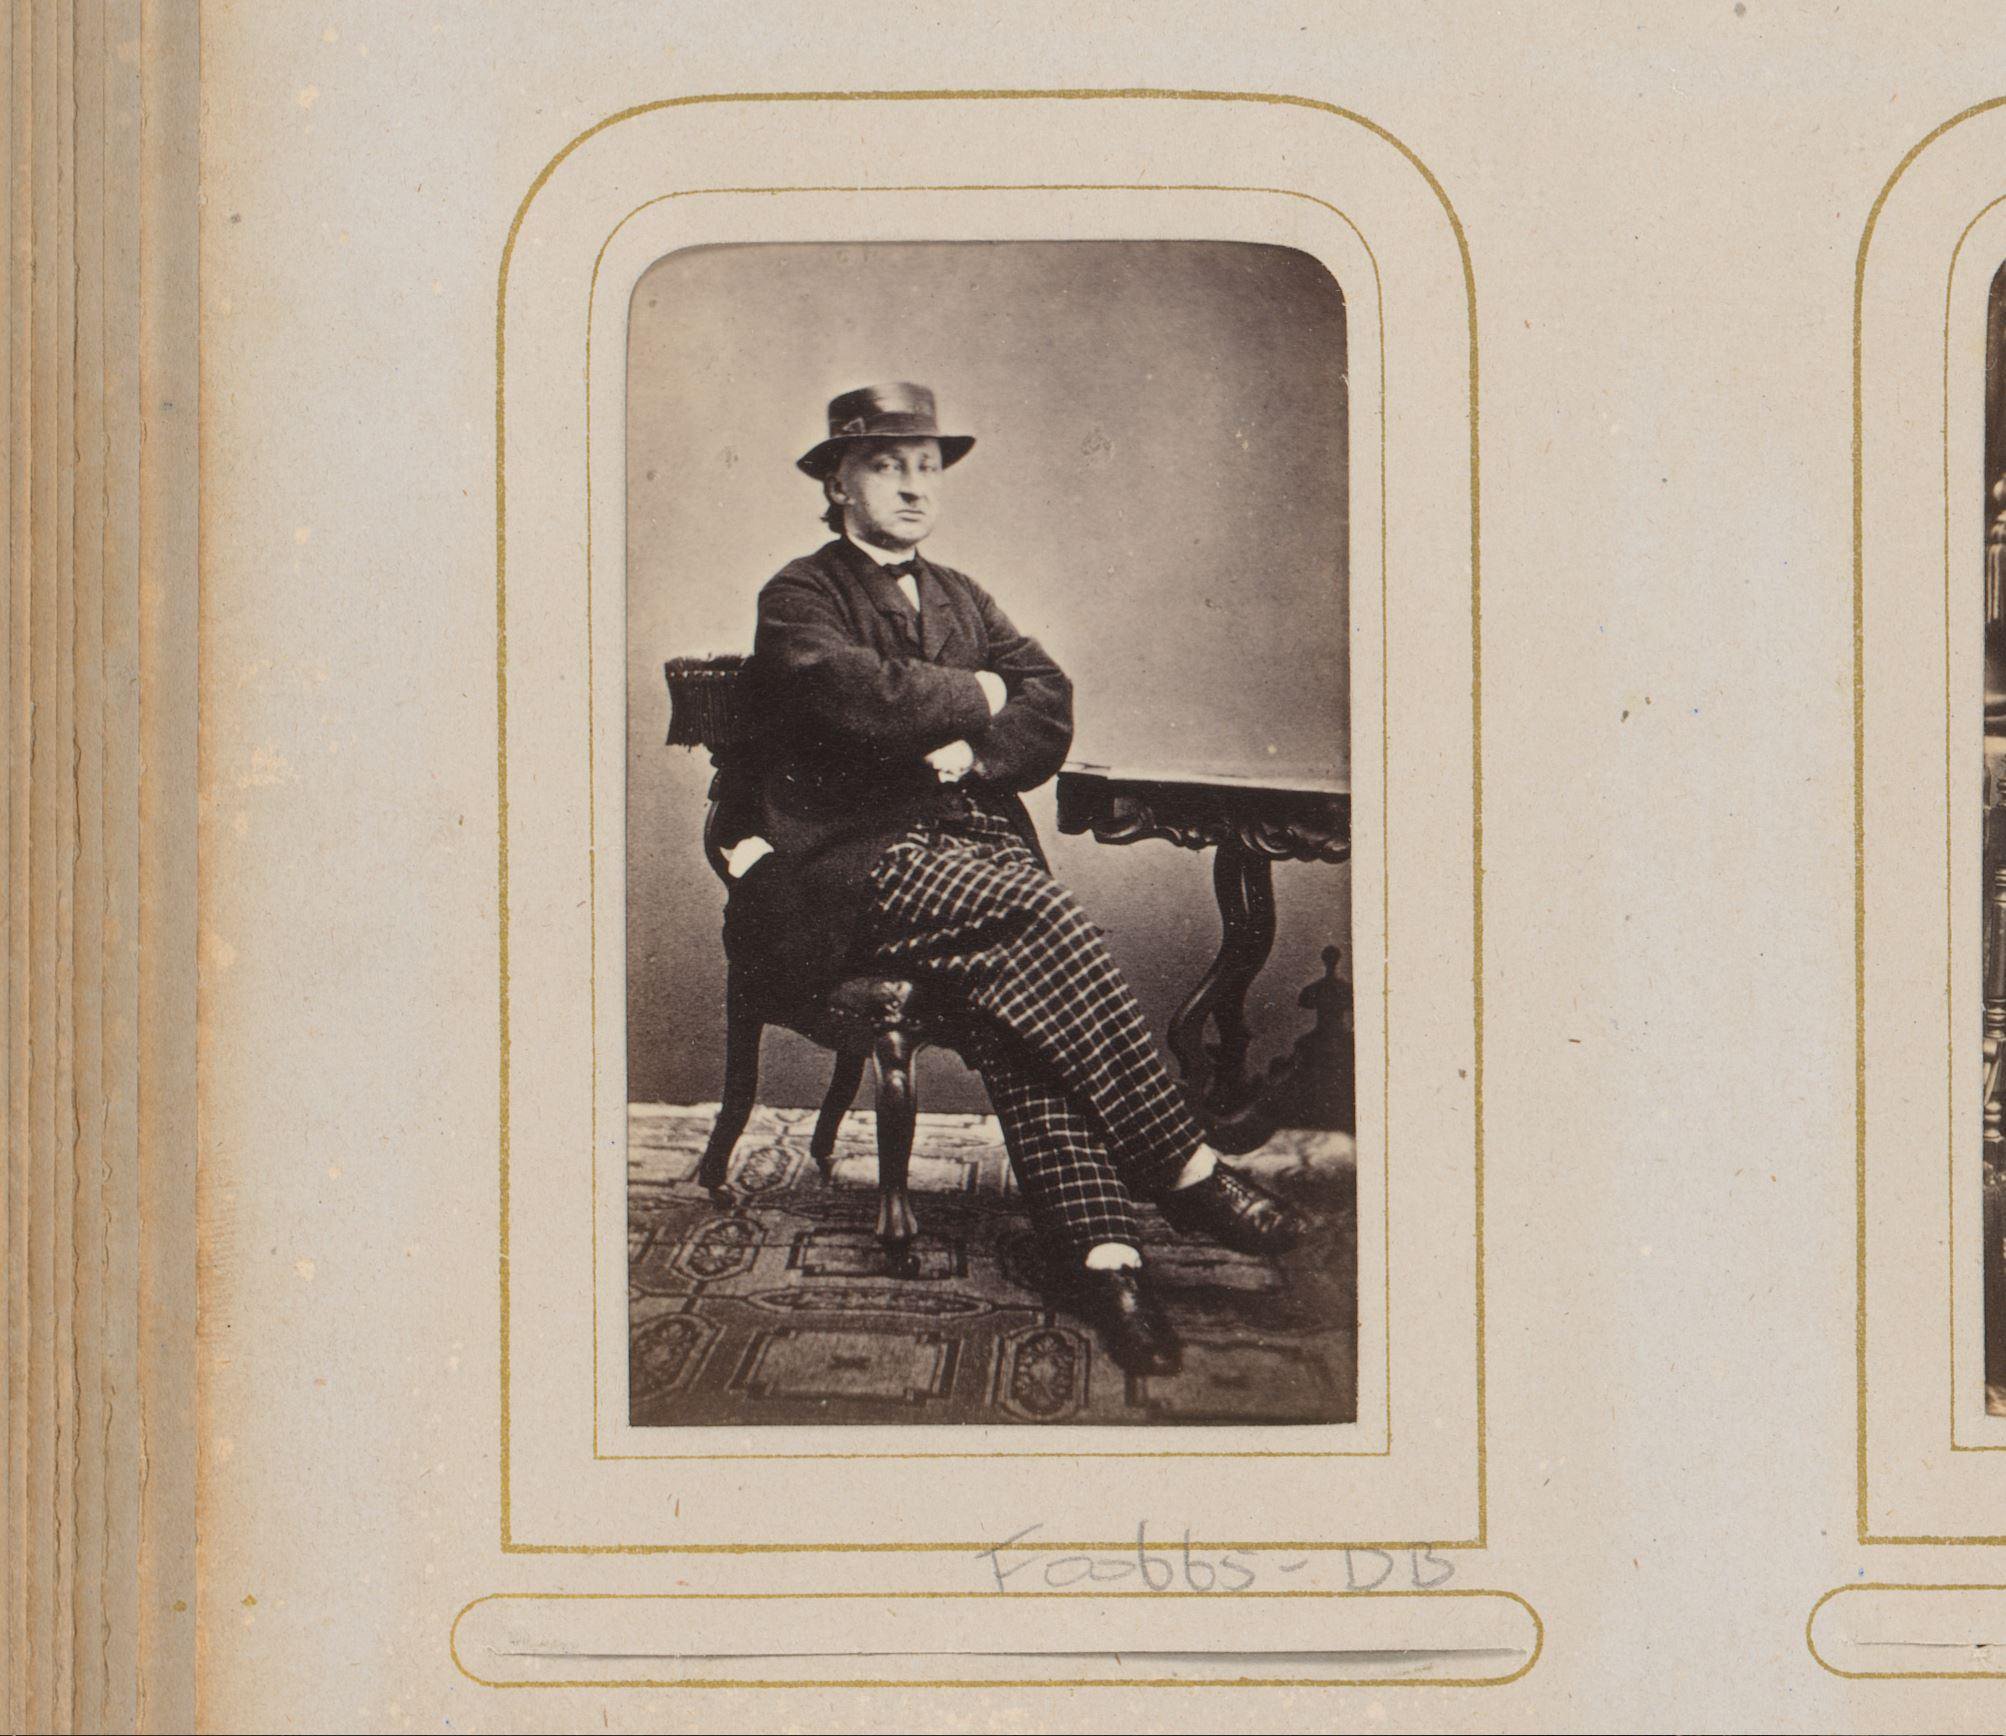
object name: carte de visite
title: Portret van een man met platte hoed bij een tafel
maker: hermanus siderius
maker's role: draughtsman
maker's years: 1819-1892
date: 1855-1880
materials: cardboard, photographic support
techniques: albumen print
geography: harlingen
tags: gloves, mittens, etc., historical persons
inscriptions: annotation: ‘H. Siderius/ Phot./ Harlingen/ [...]’